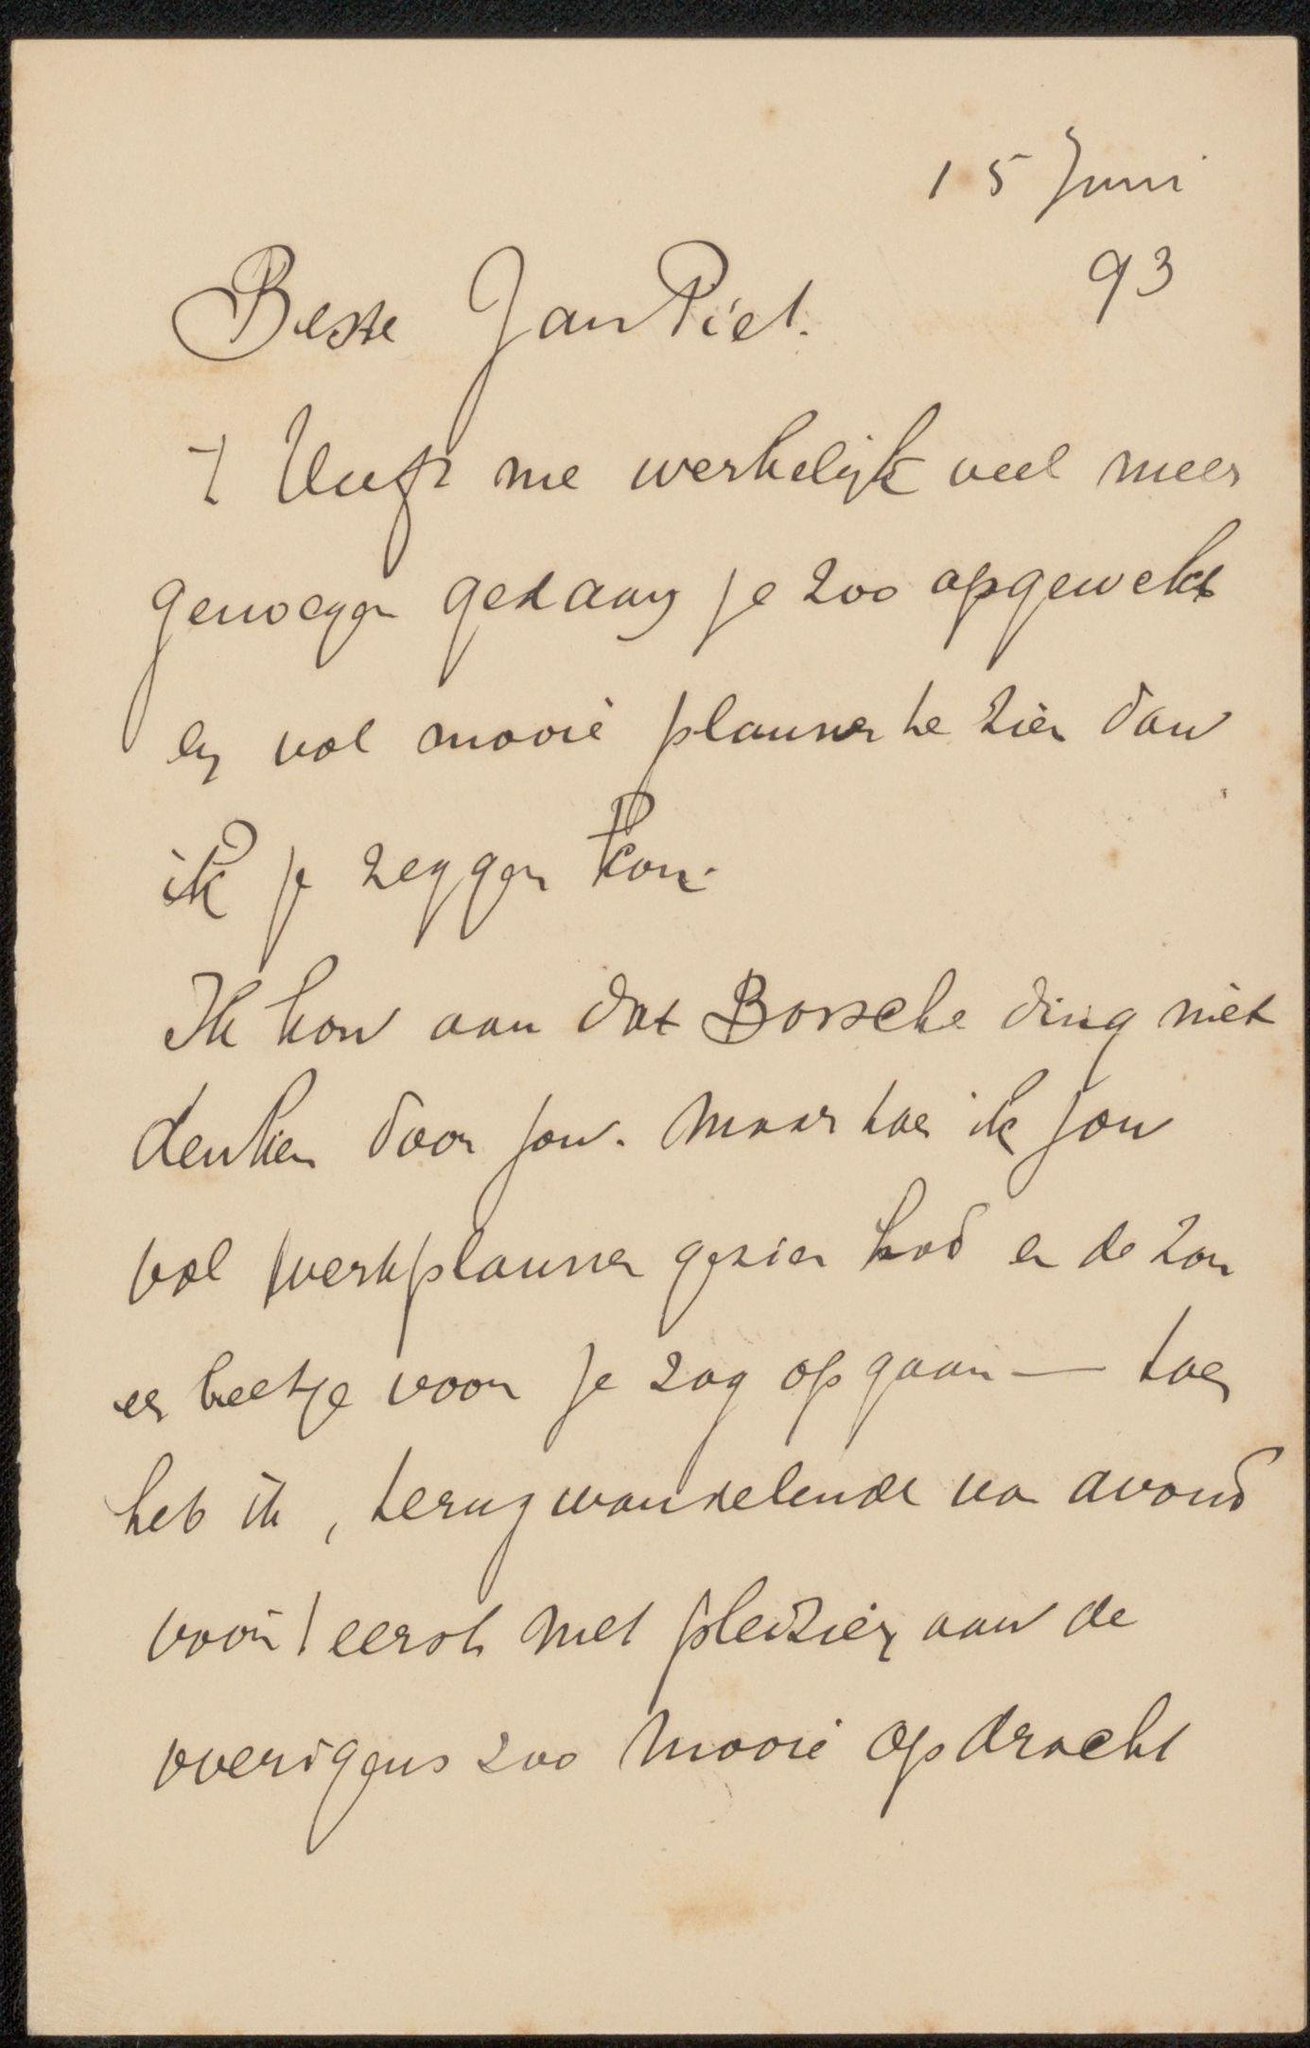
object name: letter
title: Brief aan Jan Veth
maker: antoon derkinderen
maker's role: draughtsman, painter, print maker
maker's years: 1859-1925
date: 1874-1925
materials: ink, paper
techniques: pen, writing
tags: amsterdam, painter, print maker, draughtsman, designer, jan veth, italy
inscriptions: collector's mark: ‘RPK’